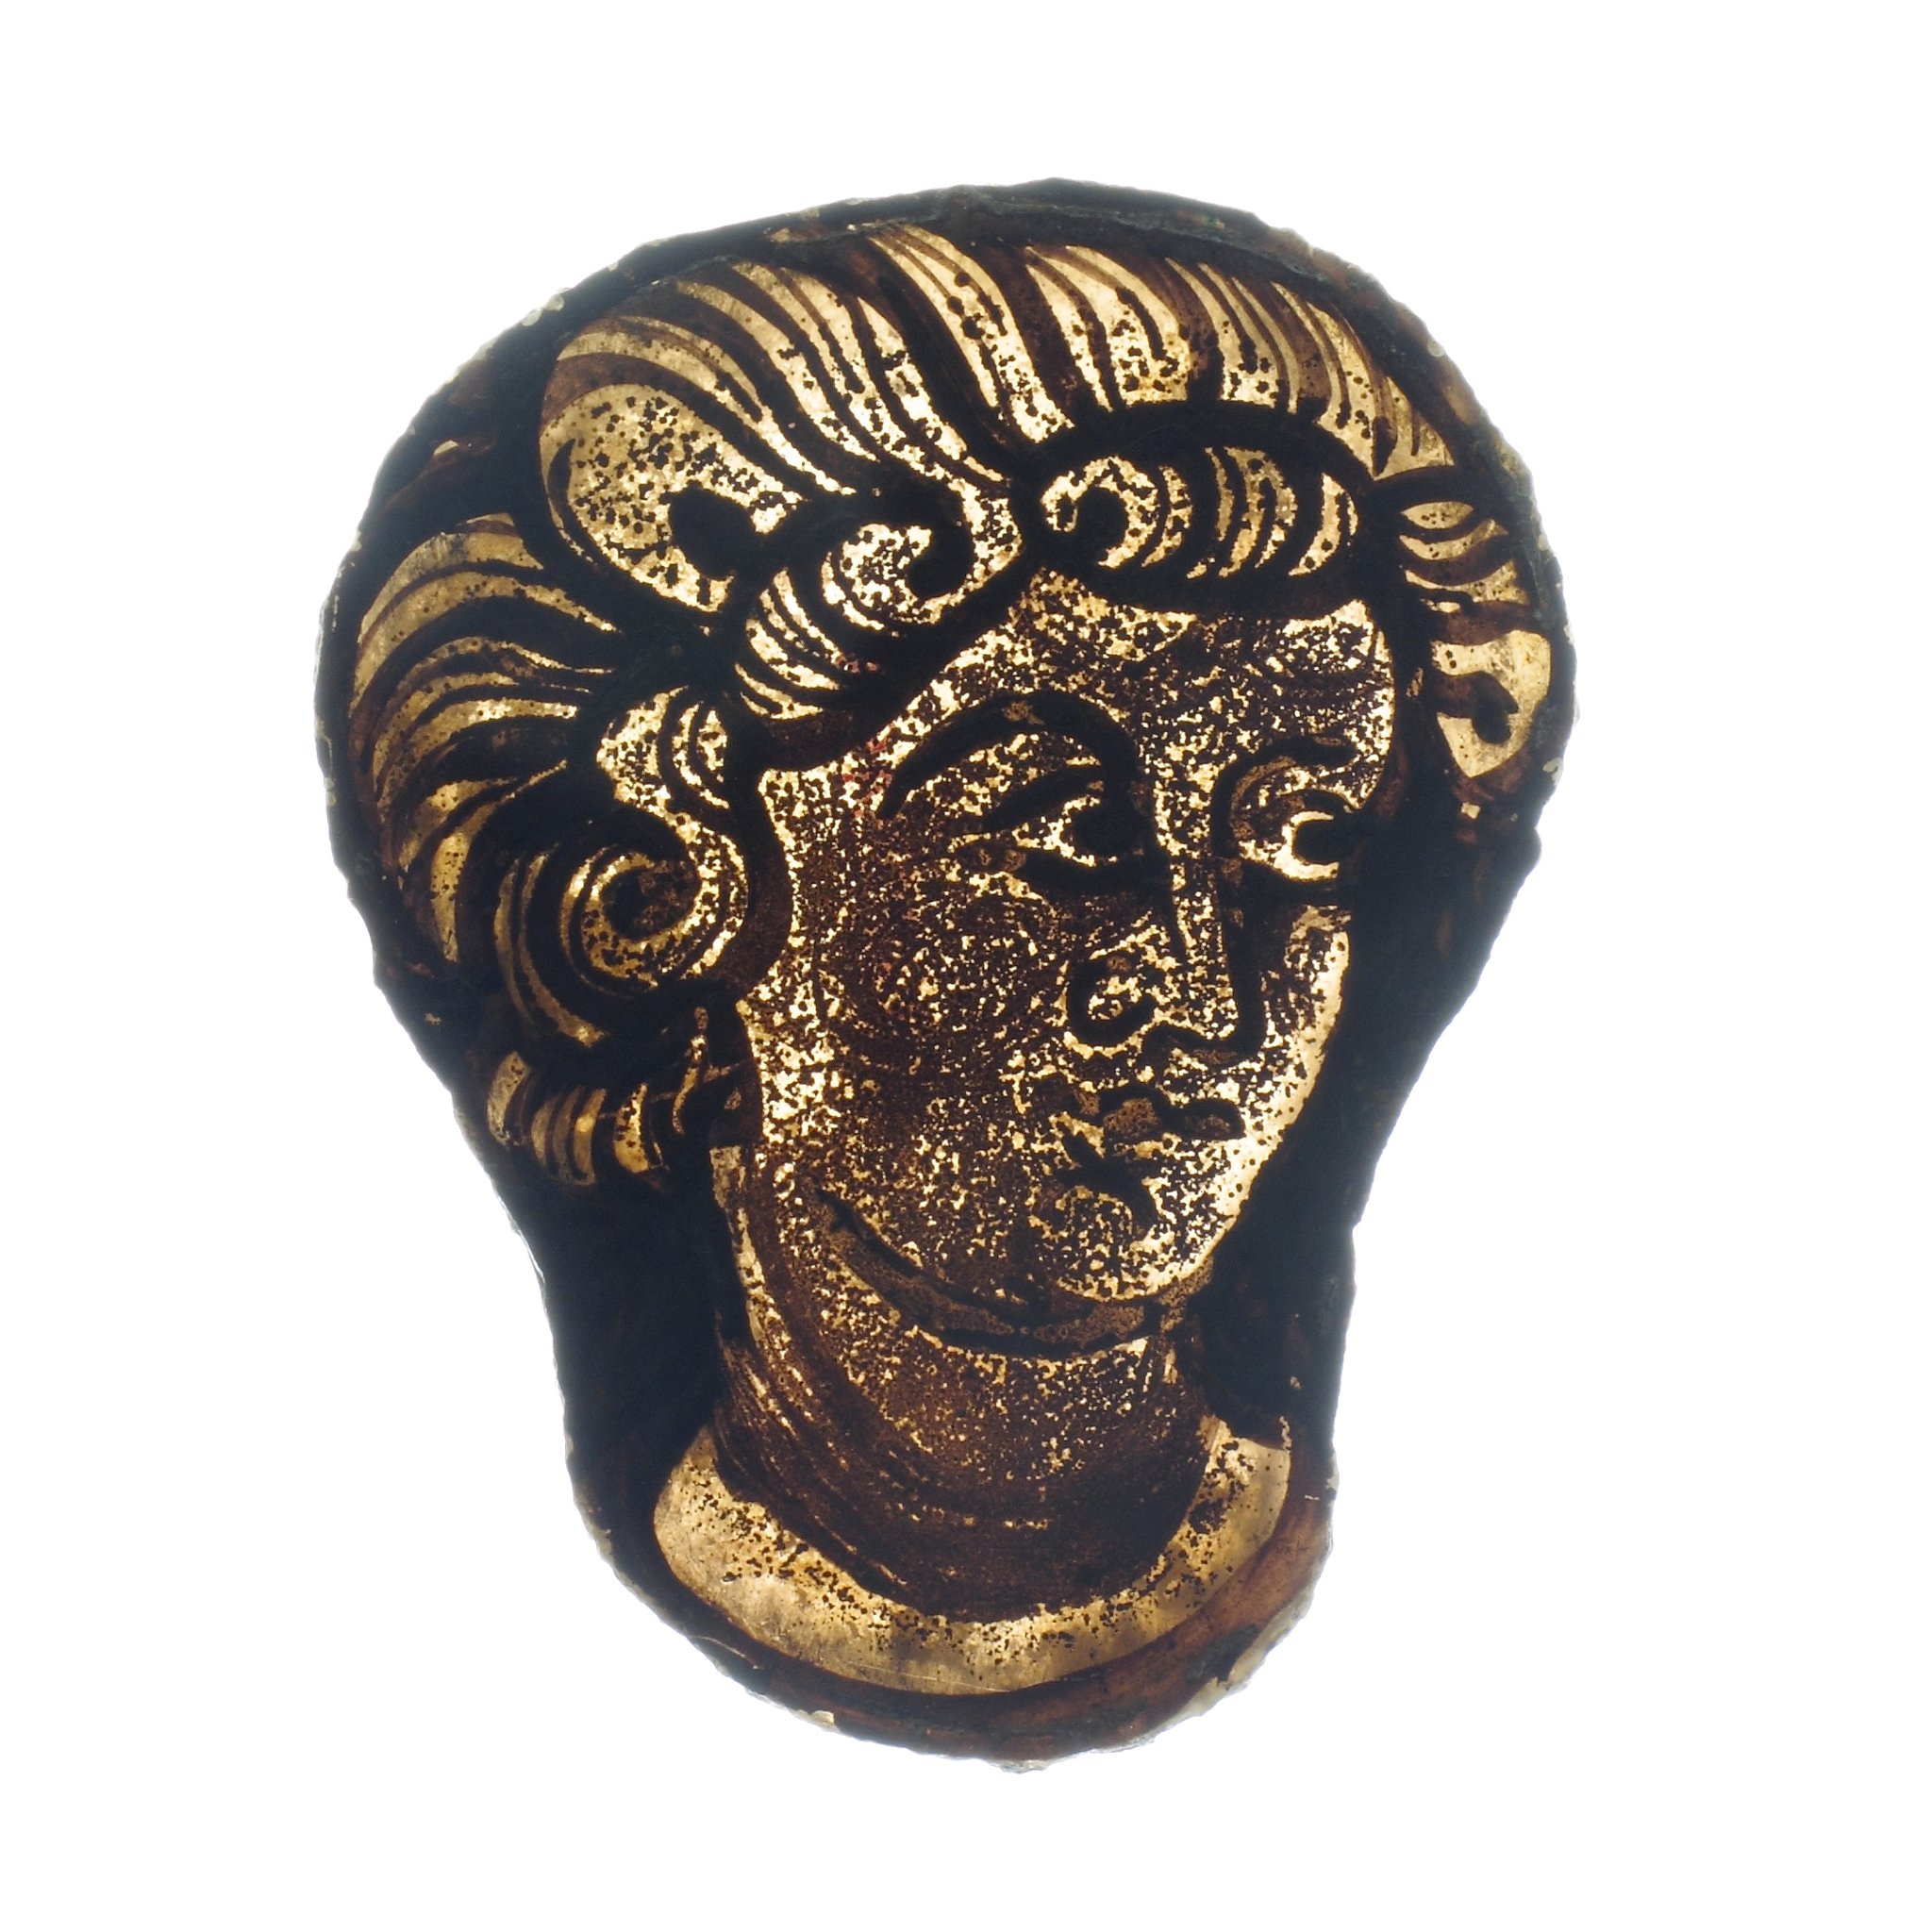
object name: fragment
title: Glass Fragment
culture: french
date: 1101-1400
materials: glass, metal, paint